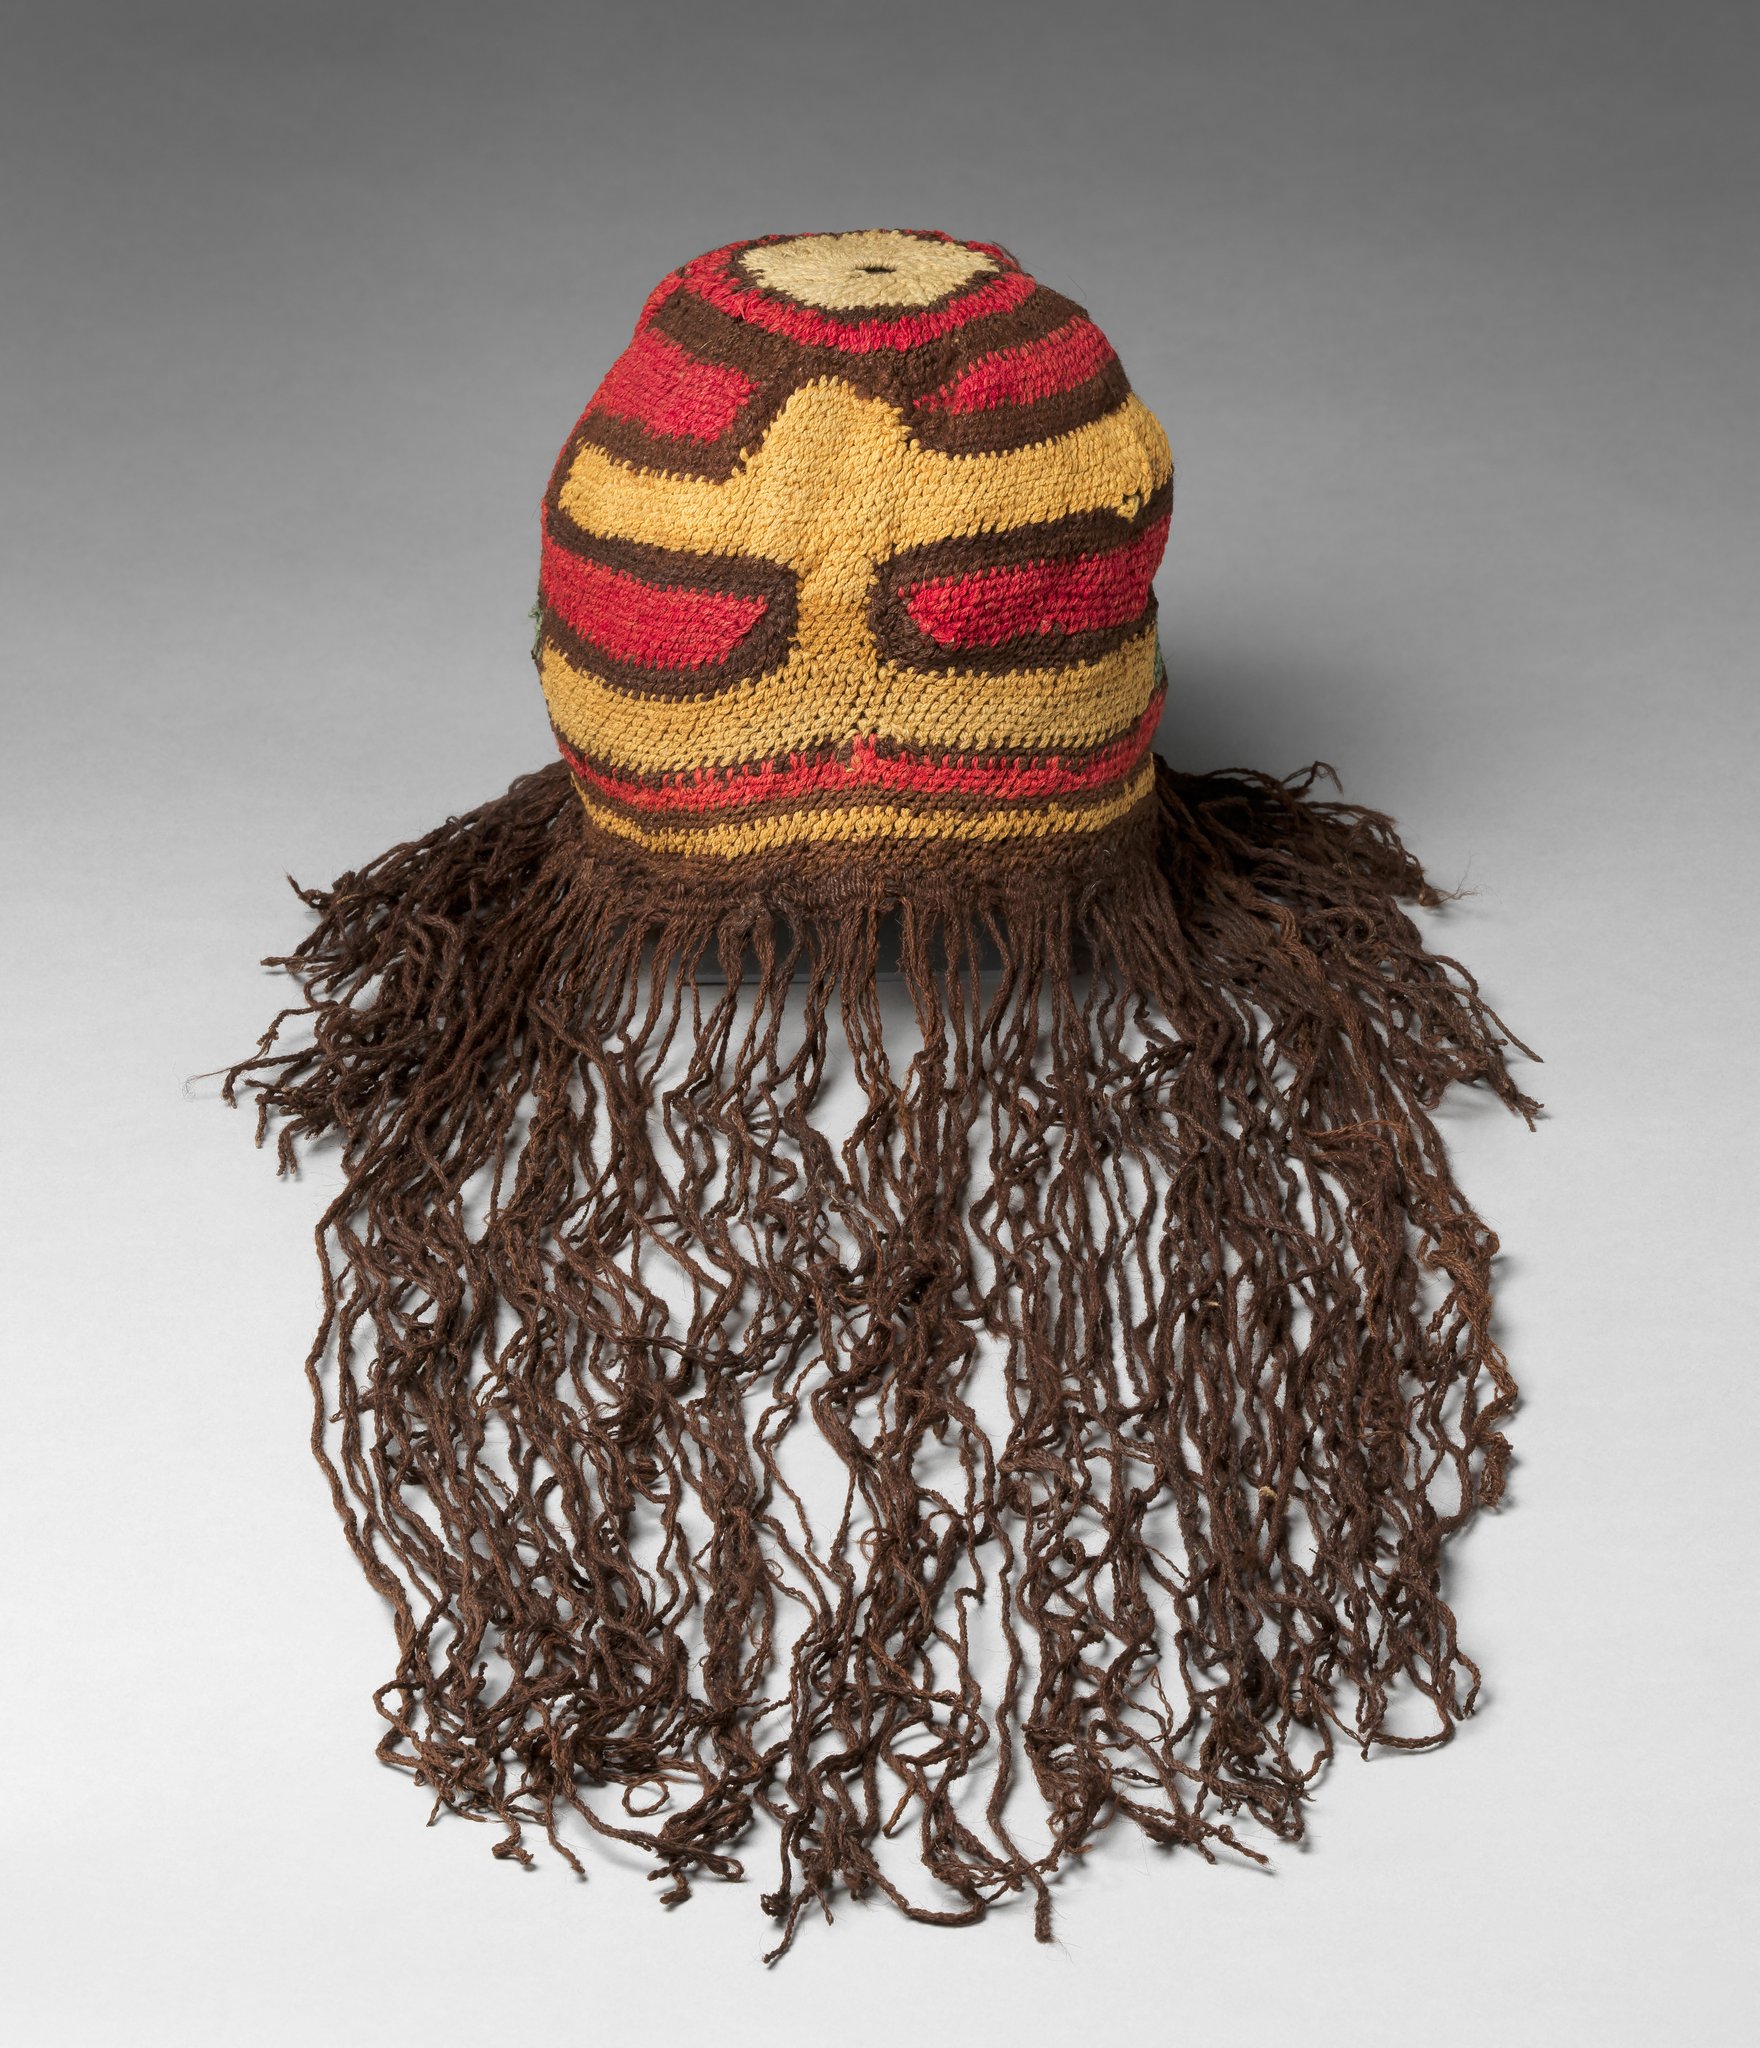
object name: hat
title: Cap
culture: peruvian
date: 601-1000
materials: animal fiber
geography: peru